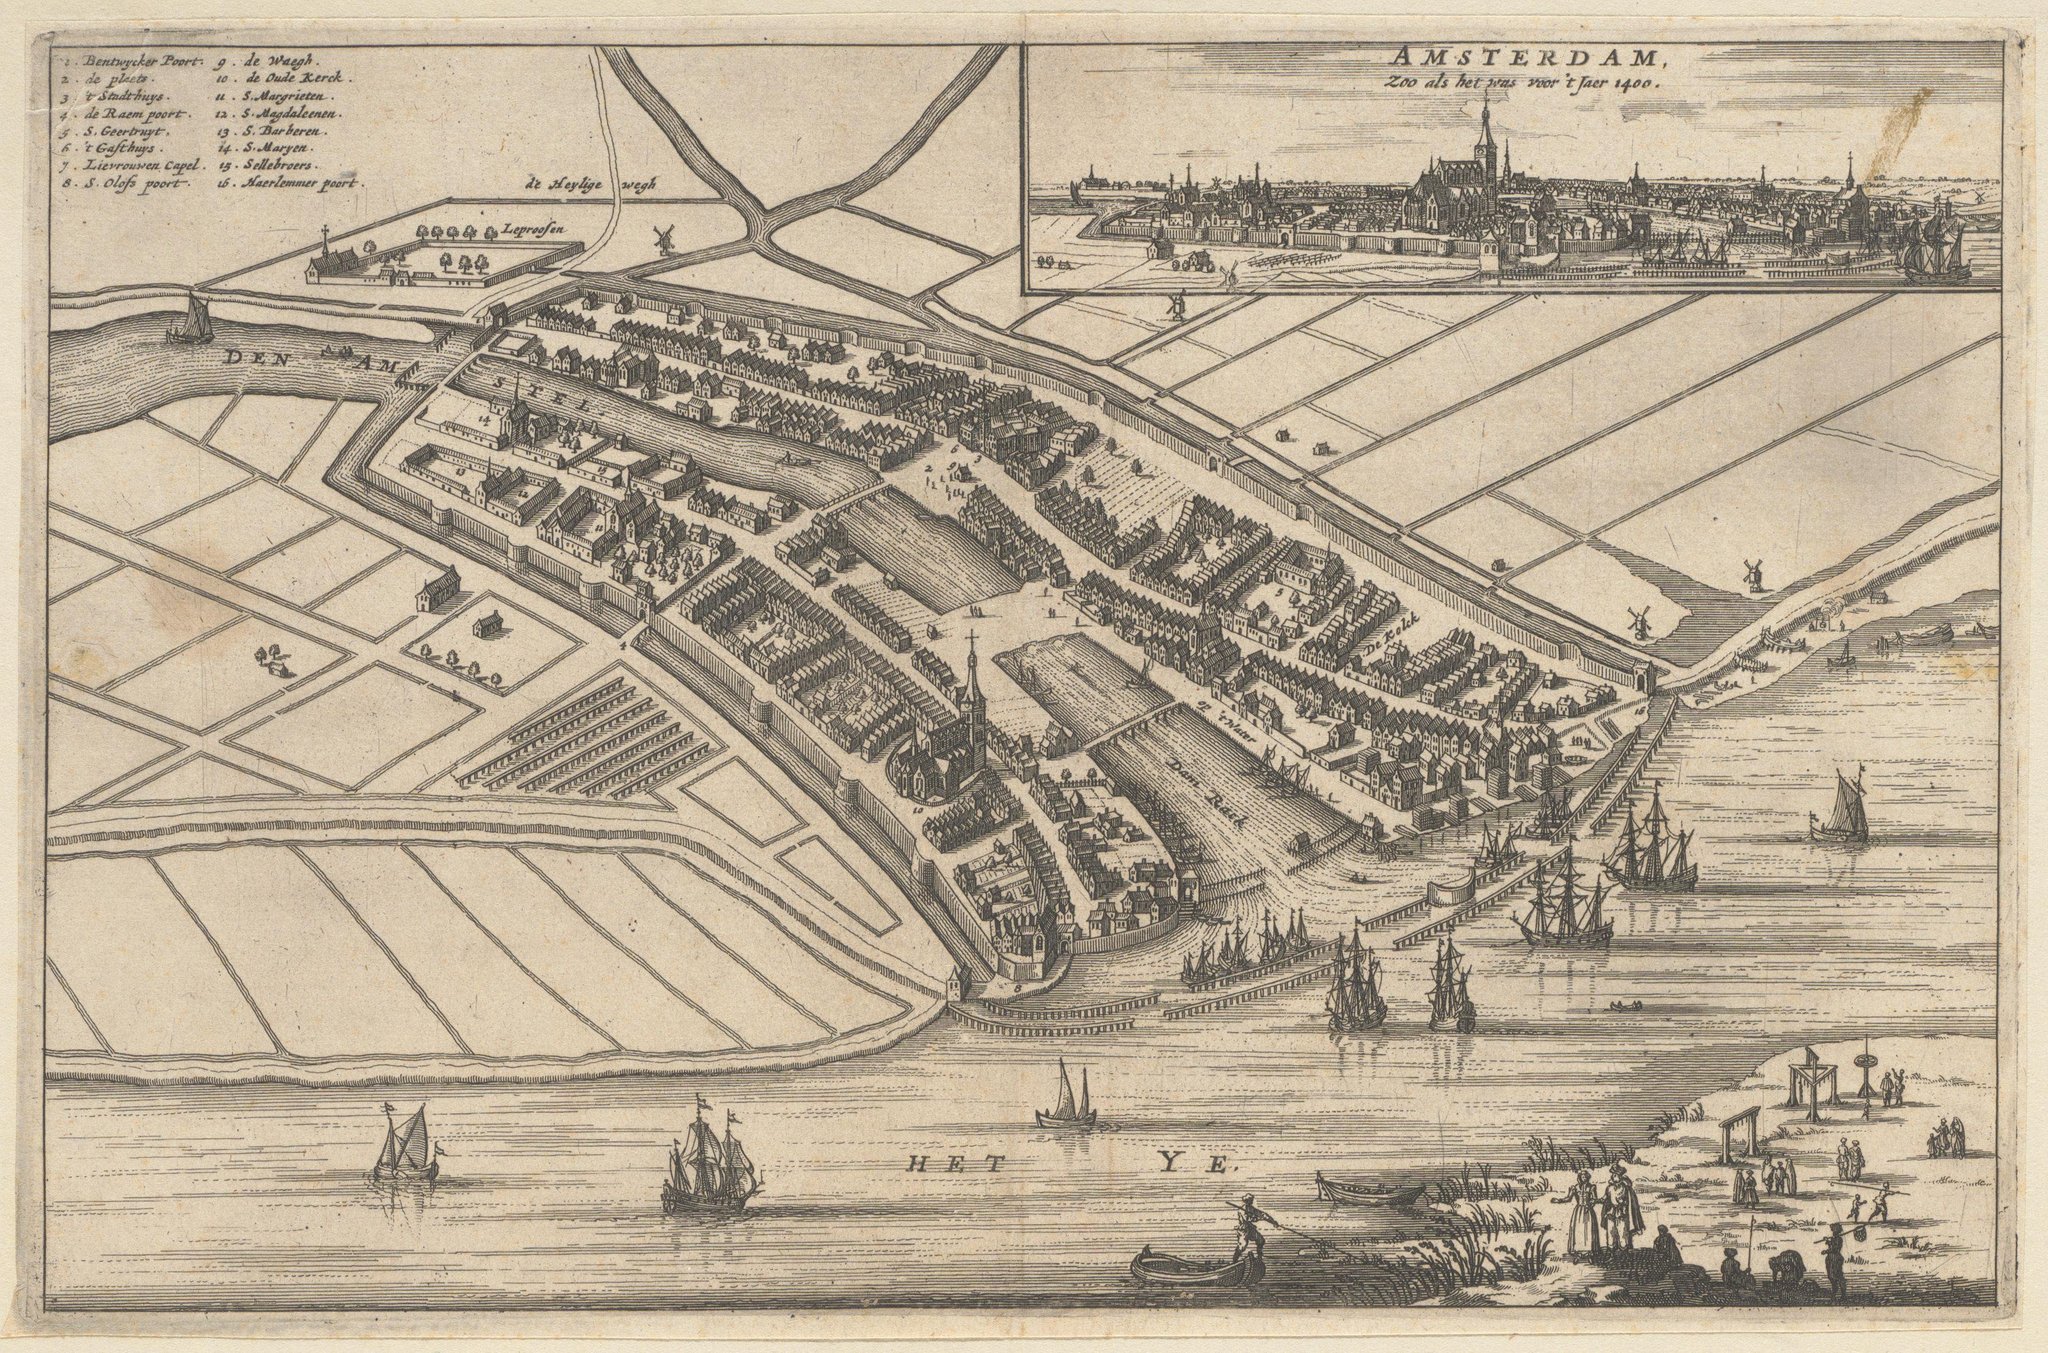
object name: print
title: Plattegrond van Amsterdam met stadsgezicht, voor 1400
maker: jacob van meurs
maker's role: draughtsman, print maker, publisher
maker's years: 1619-1680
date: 1663-1664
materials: paper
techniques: engraving, etching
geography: amsterdam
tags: maps of cities, prospect of city, town panorama, silhouette of city, amsterdam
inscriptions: collector's mark: Lugt 1641b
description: Prent mogelijk uit: Dapper, Olfert. Historische beschryving der stadt Amsterdam (…). Amsterdam: Jacob van Meurs, 1663. Of uit: Zesen, Philipp von. Beschreibung der Stadt Amsterdam (…). Amsterdam: Joachim Nosche, 1664.